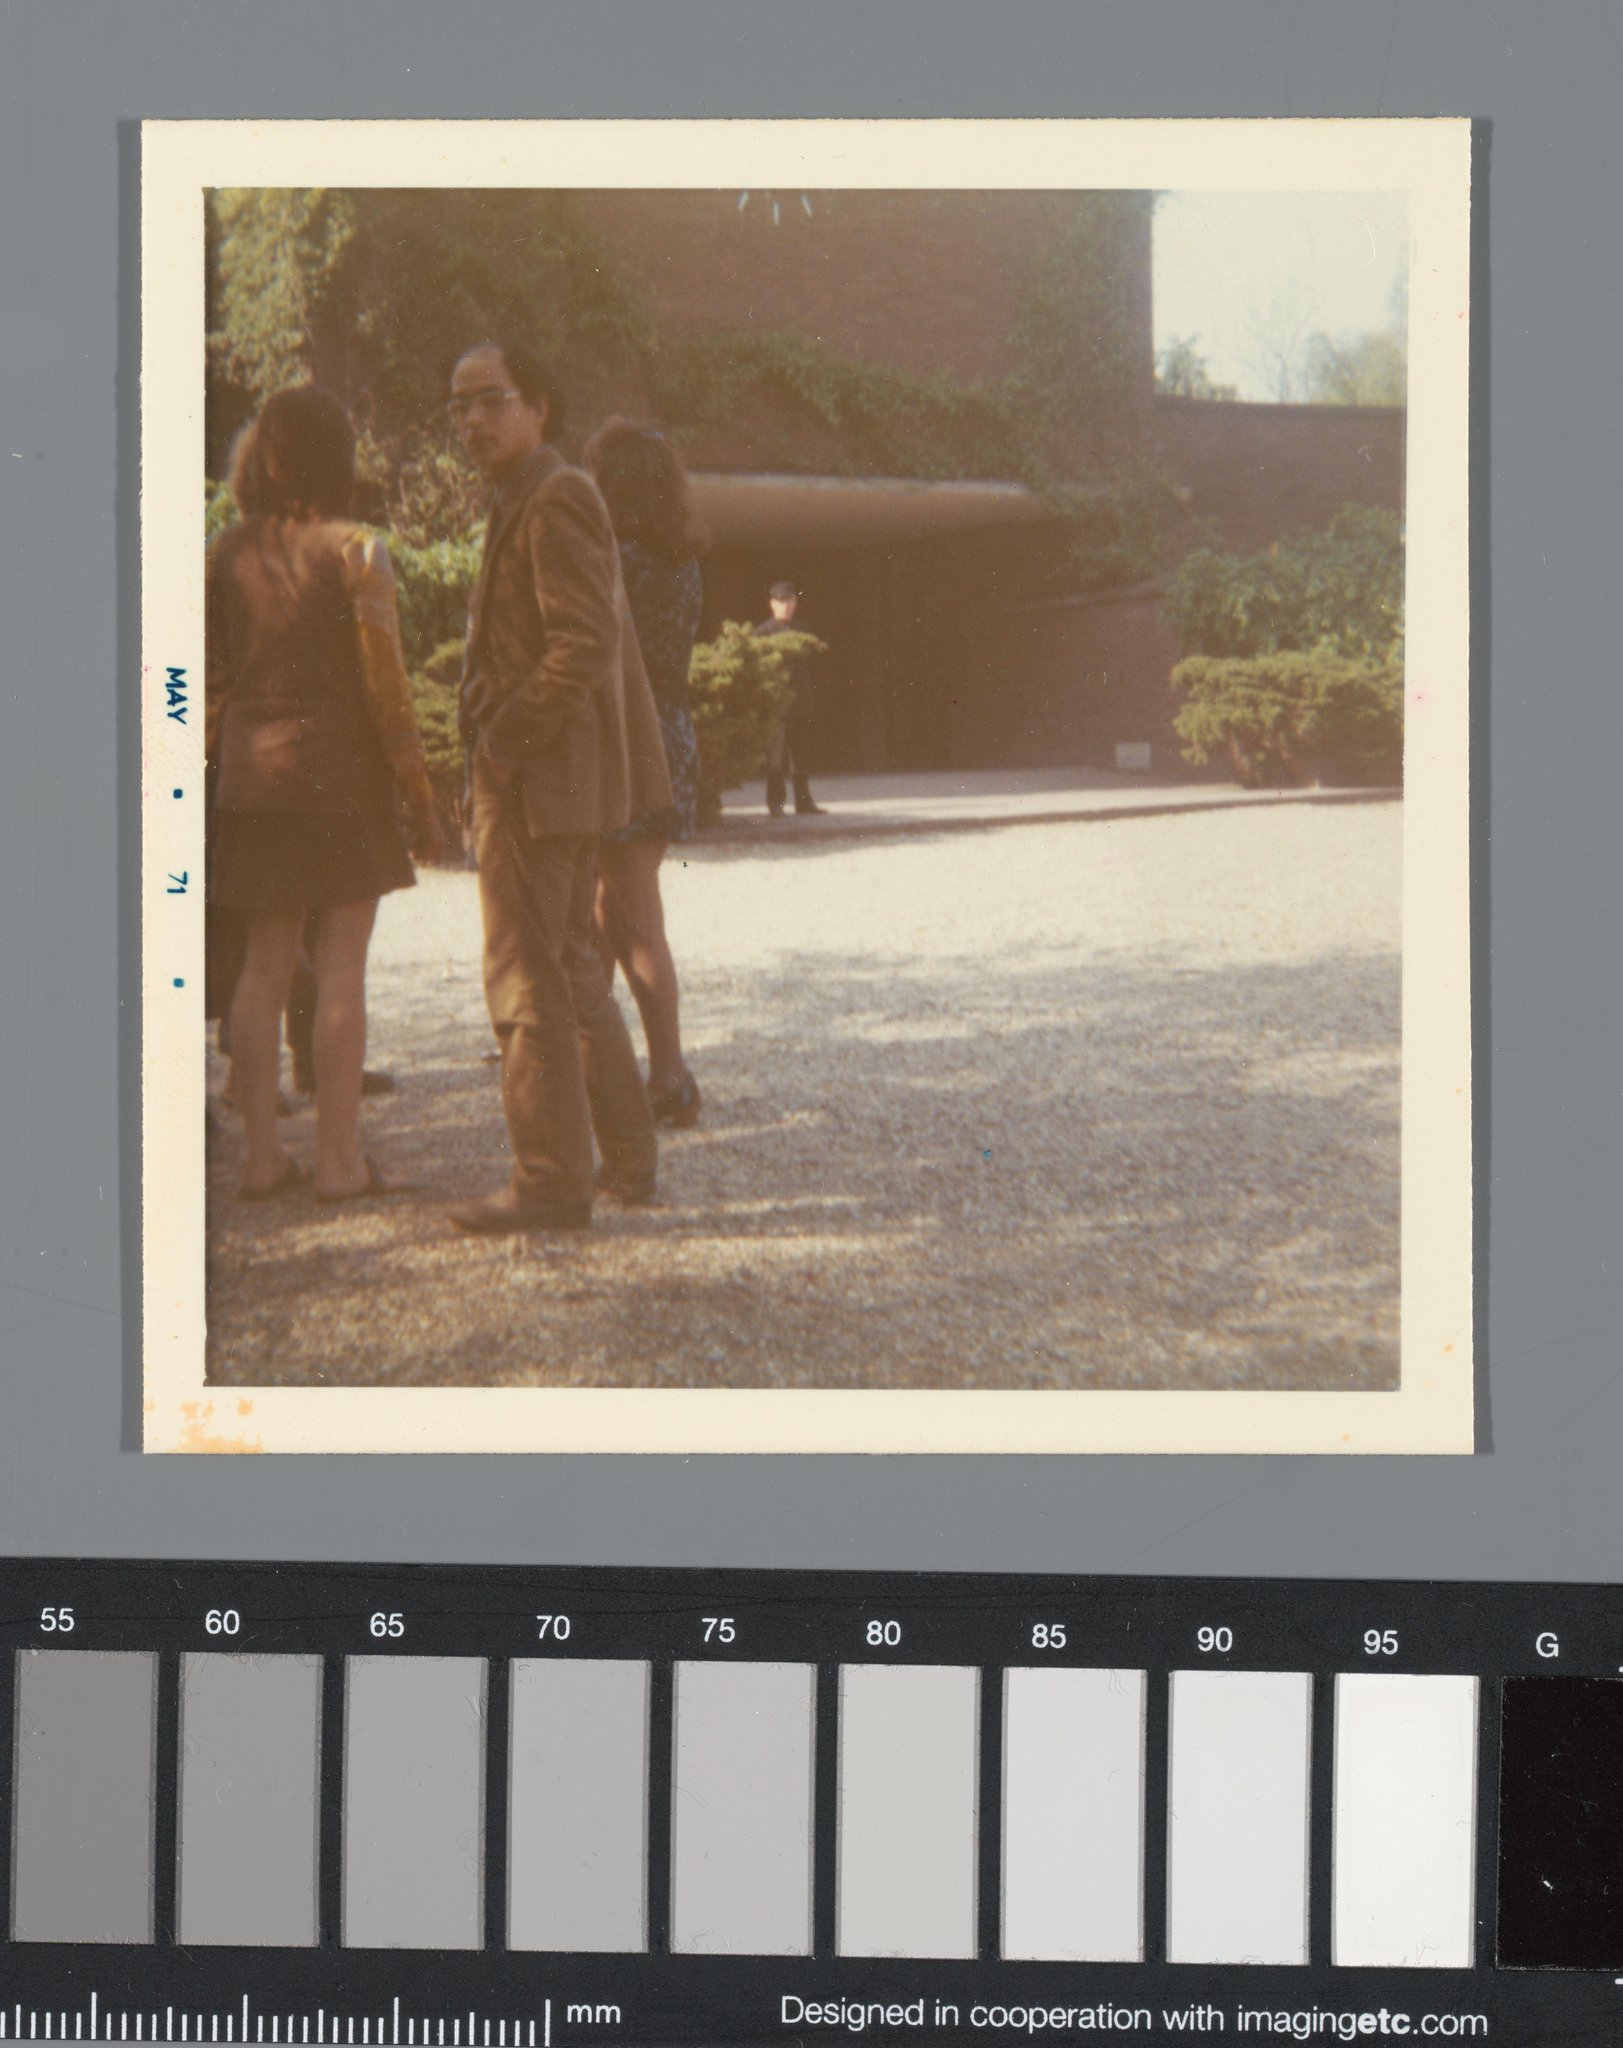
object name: photograph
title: Groep mensen tijdens een begrafenis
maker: cornelia hendrika jonker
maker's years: 1874-1924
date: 1971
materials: photographic support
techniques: chromogenic print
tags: historical persons, funerary ceremonial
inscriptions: stamp: ‘Kodacolor Print’, annotation: ‘Jen-Sies-Fransje’, inscription: ‘May 71’